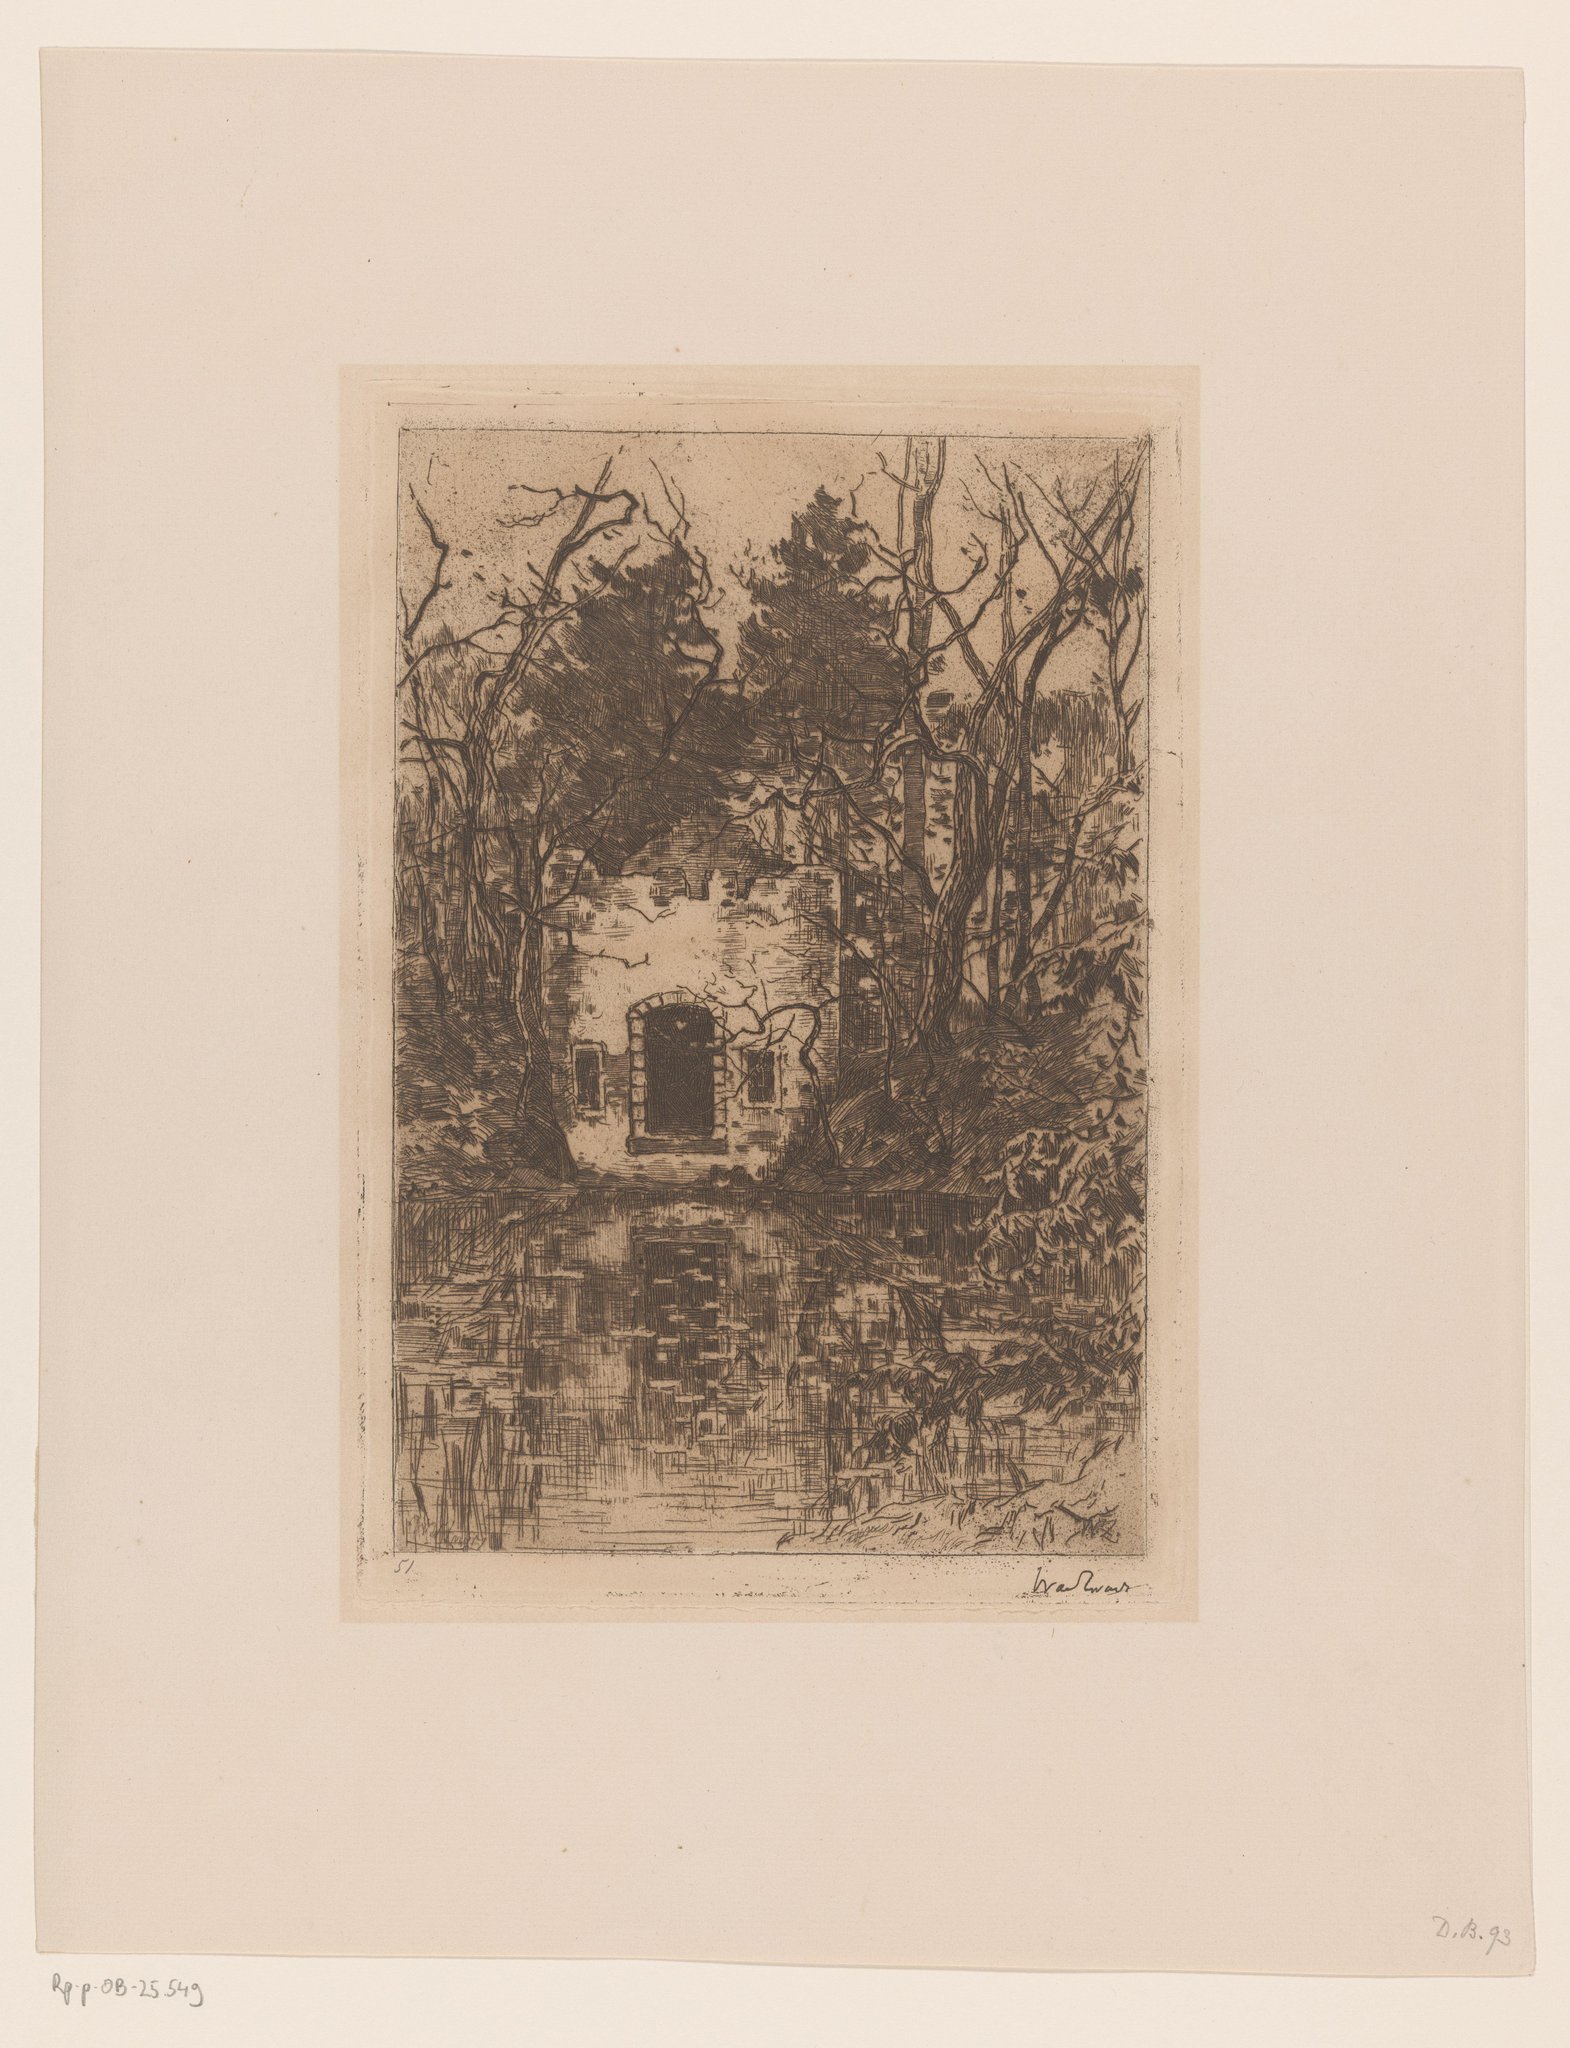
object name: print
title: Ruïne aan een vijver (Lage Vuursche)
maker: willem de zwart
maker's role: draughtsman, painter, print maker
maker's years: 1862-1931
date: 1896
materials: paper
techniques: etching, intaglio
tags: landscape with ruins, pond, pool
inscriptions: collector's mark: Lugt 2228